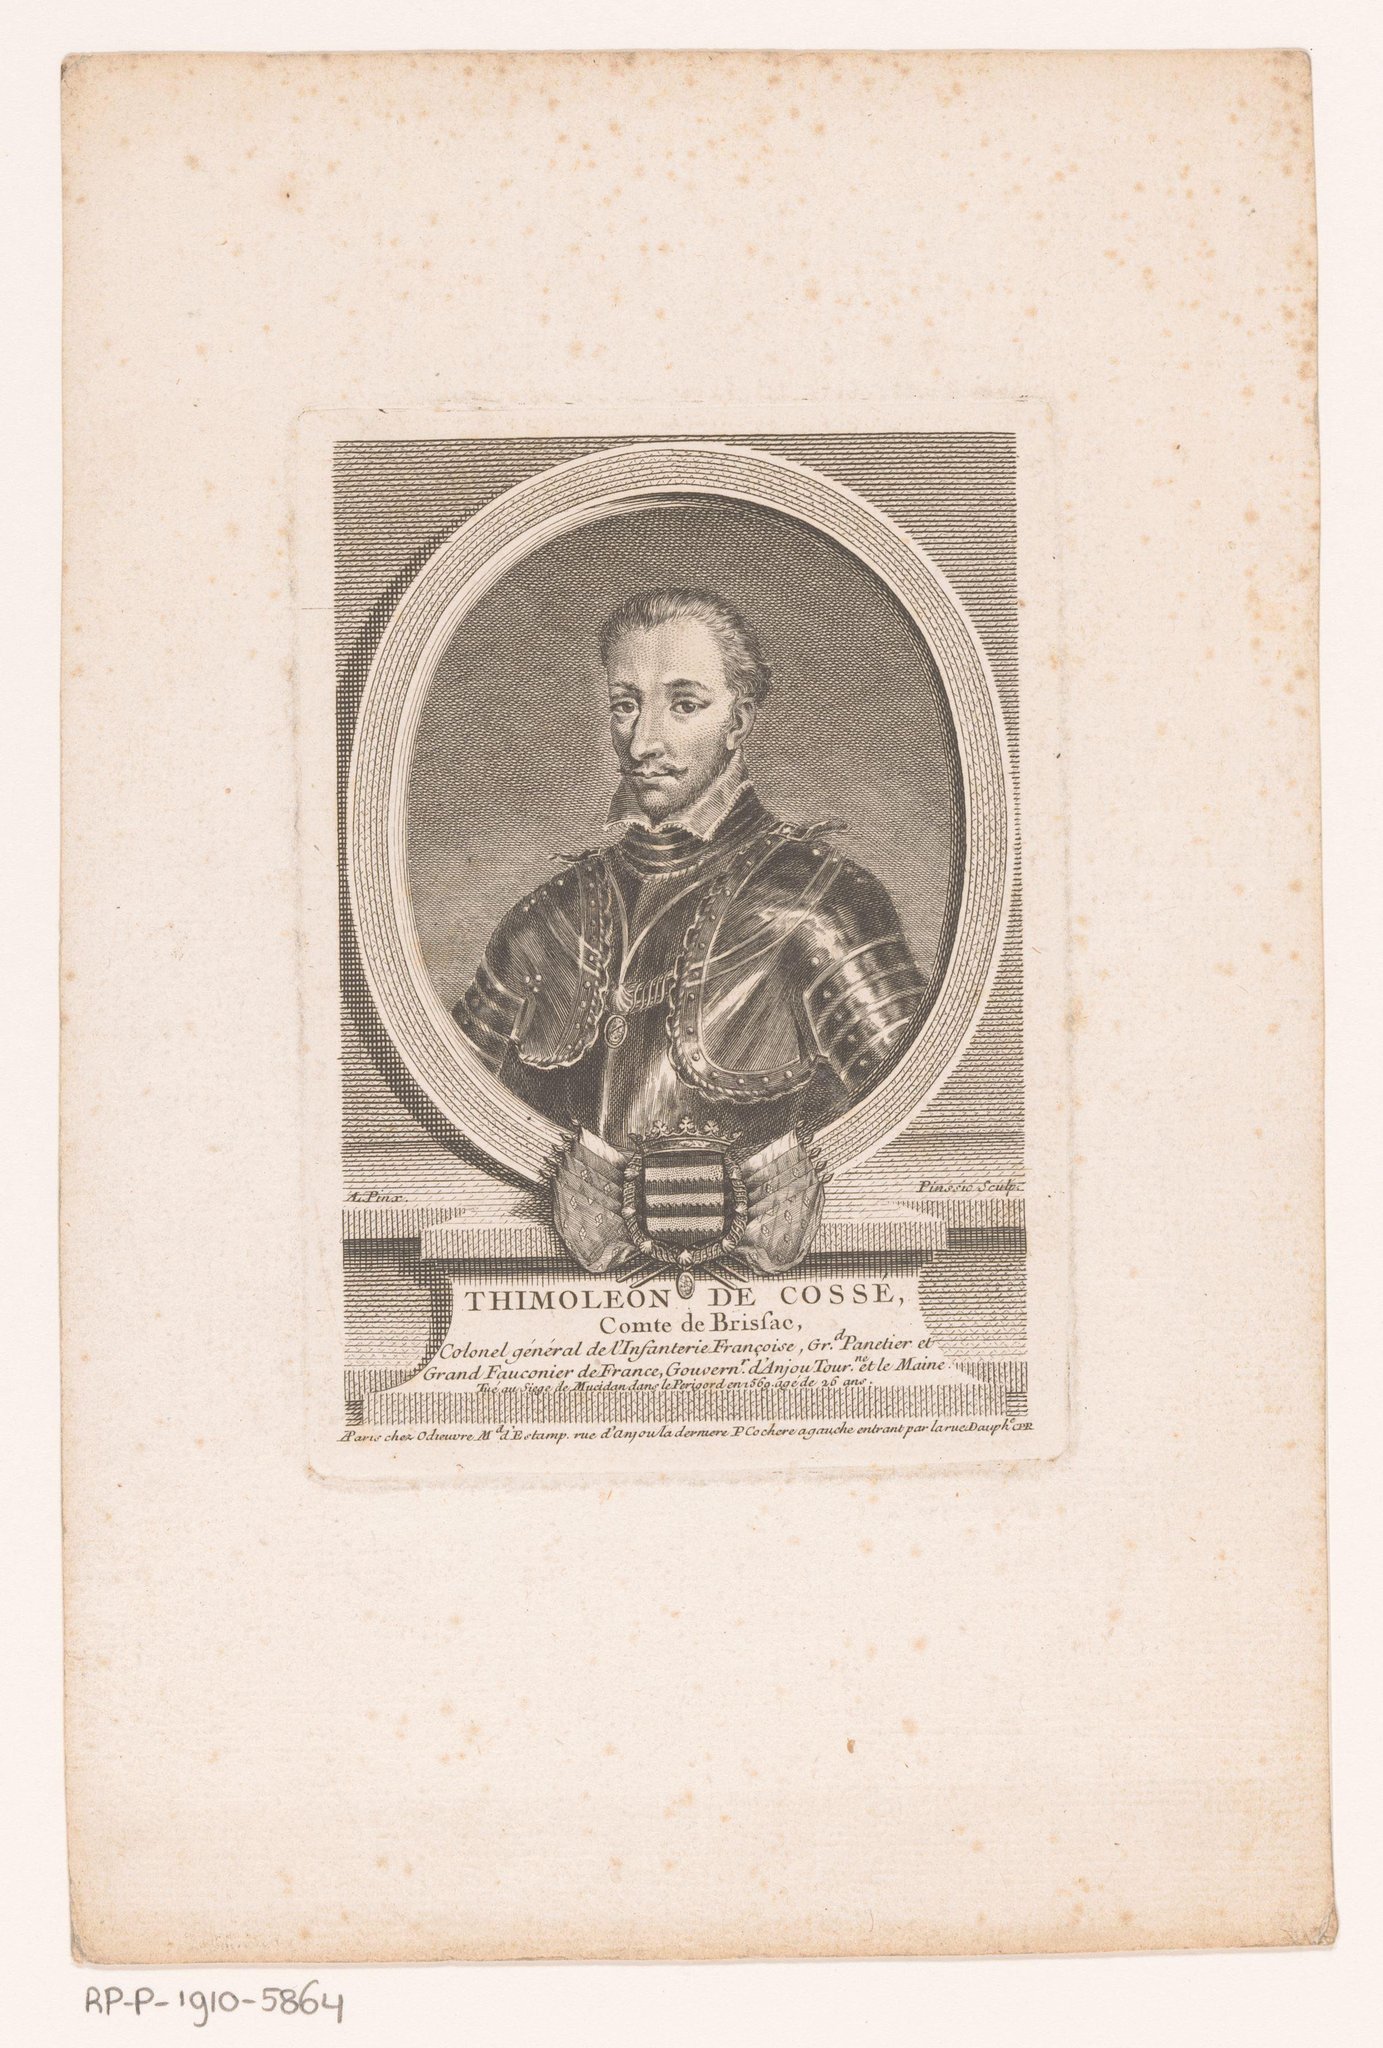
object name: print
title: Portret van Timoléon de Cossé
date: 1755-1765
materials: paper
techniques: engraving, etching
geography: france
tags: ranks in the army, historical persons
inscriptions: collector's mark: Lugt 2228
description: Prent uit: Dreux du Radier, Jean-François. L'Europe illustré, contenant l'histoire abregée des souverains, des princes, des prélats, des ministres, (...) en Europe: dans le XVe. siècle compris, jusqu'à présent. Parijs: Michel Odieuvre en André-François Le Breton, 1755-1765.